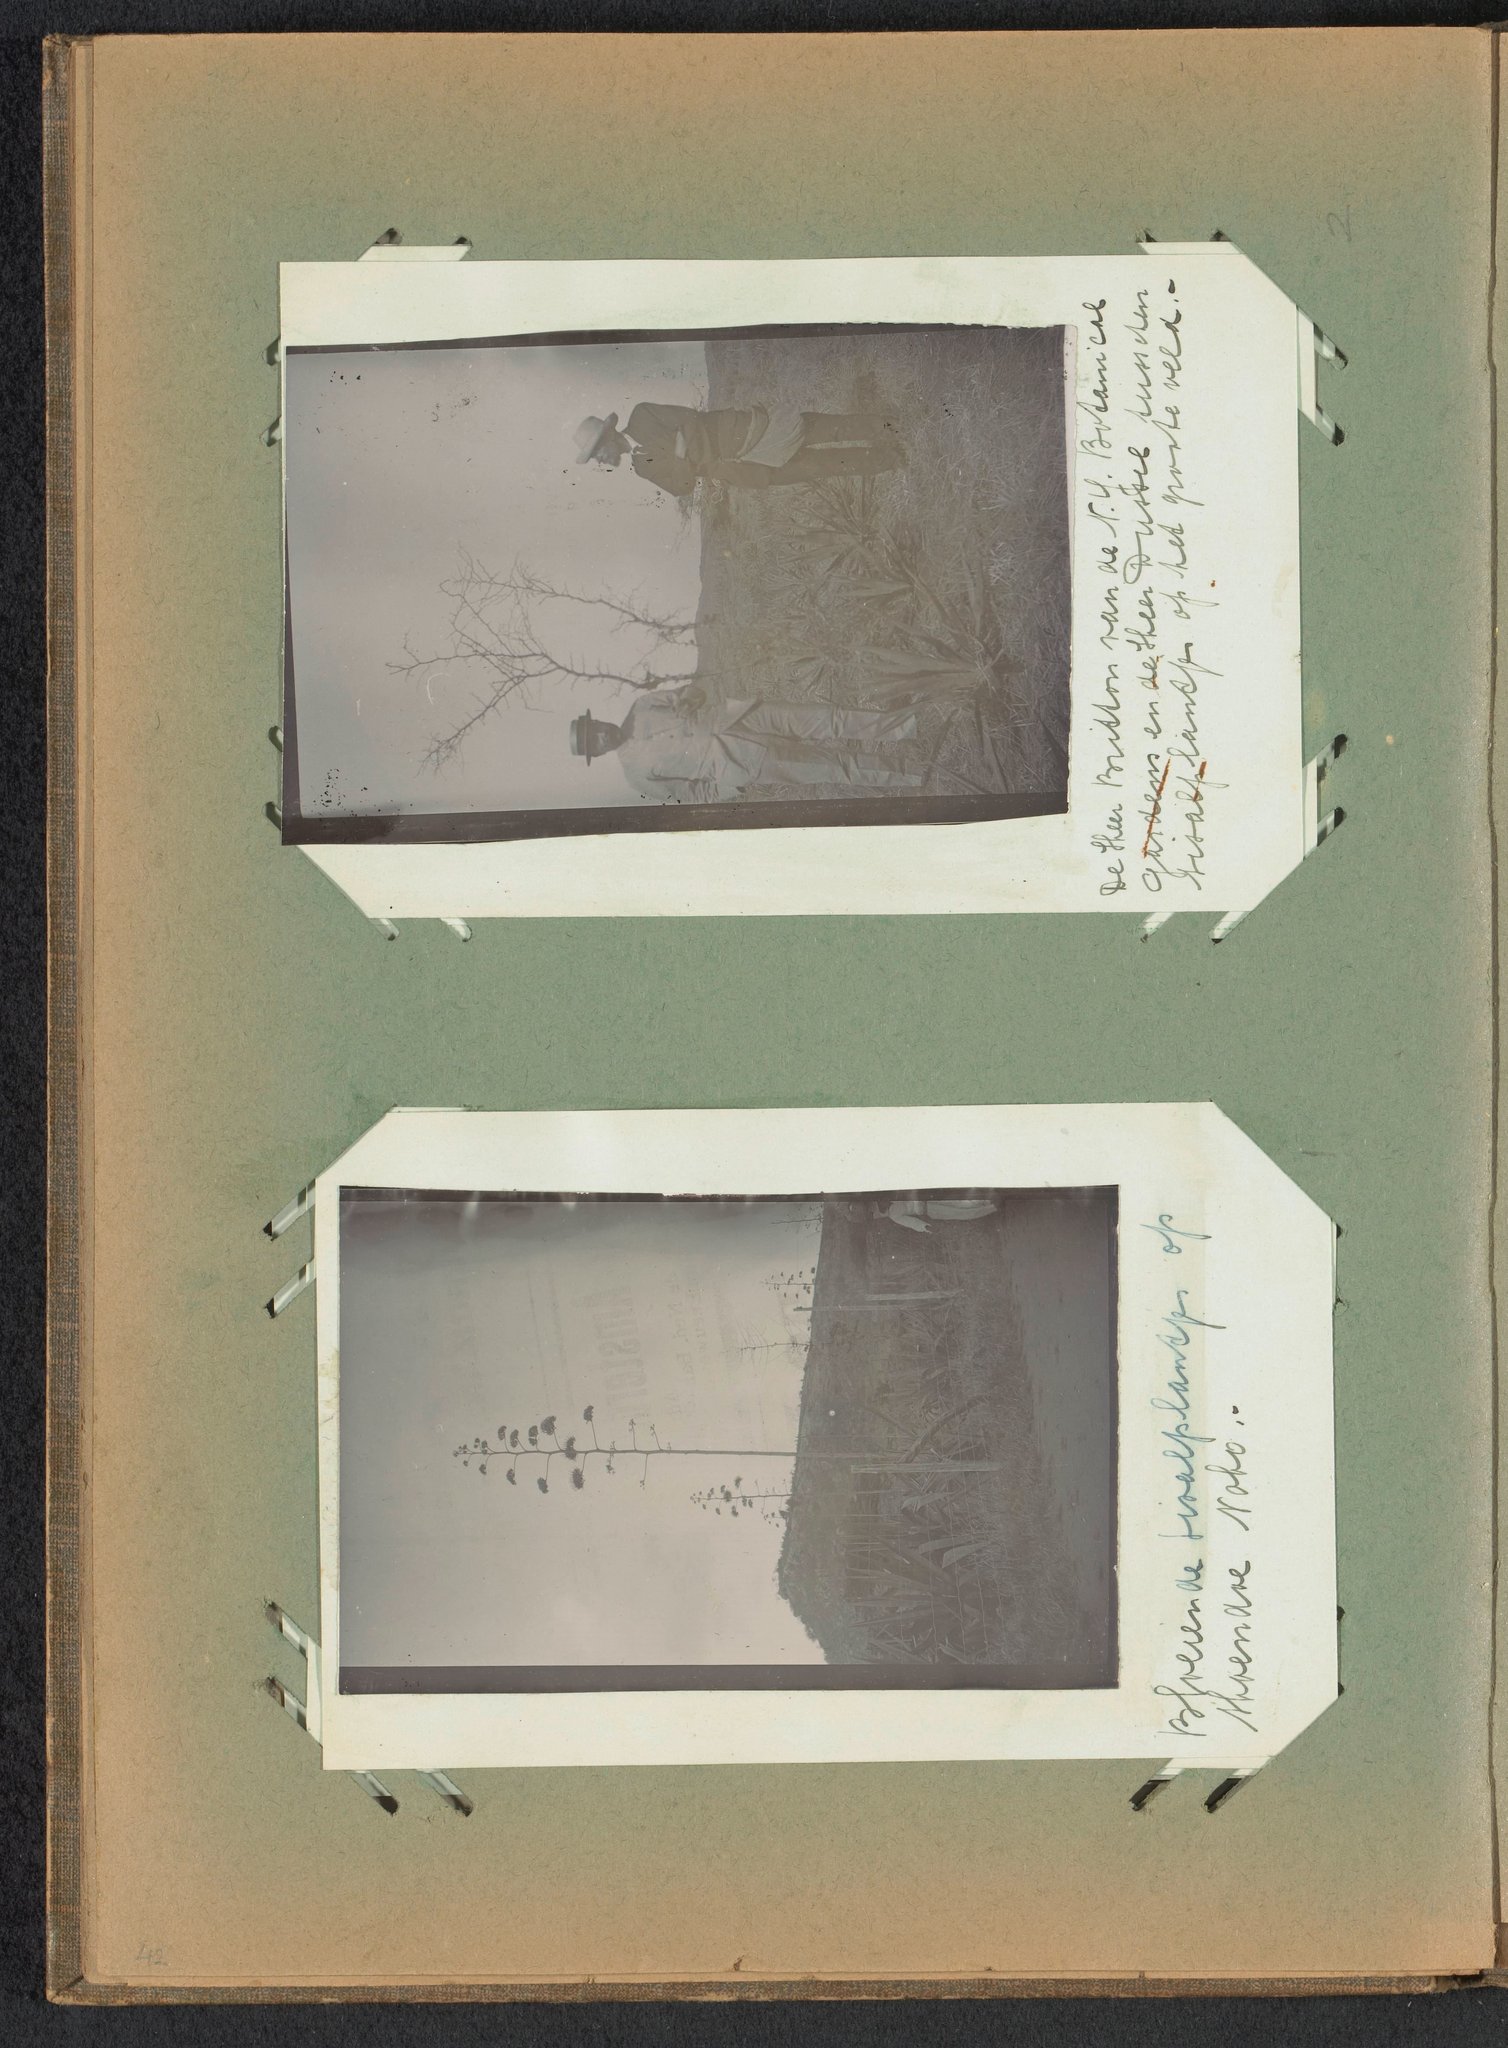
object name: photograph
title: Bloeiende sisalplanten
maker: Anonymous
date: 1912-1913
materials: paper, photographic support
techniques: gelatin silver print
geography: curacao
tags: plantation, (non-fruit) products of plants or trees: sisal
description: Bloeiende sisalplanten bij Plantage Mount Pleasant op Curaçao. Onderdeel van het fotoalbum uit ca. 1912-1913 met 92 foto's van de plantages Peperpot en Dordrecht in Suriname en Mount Pleasant op Curaçao.